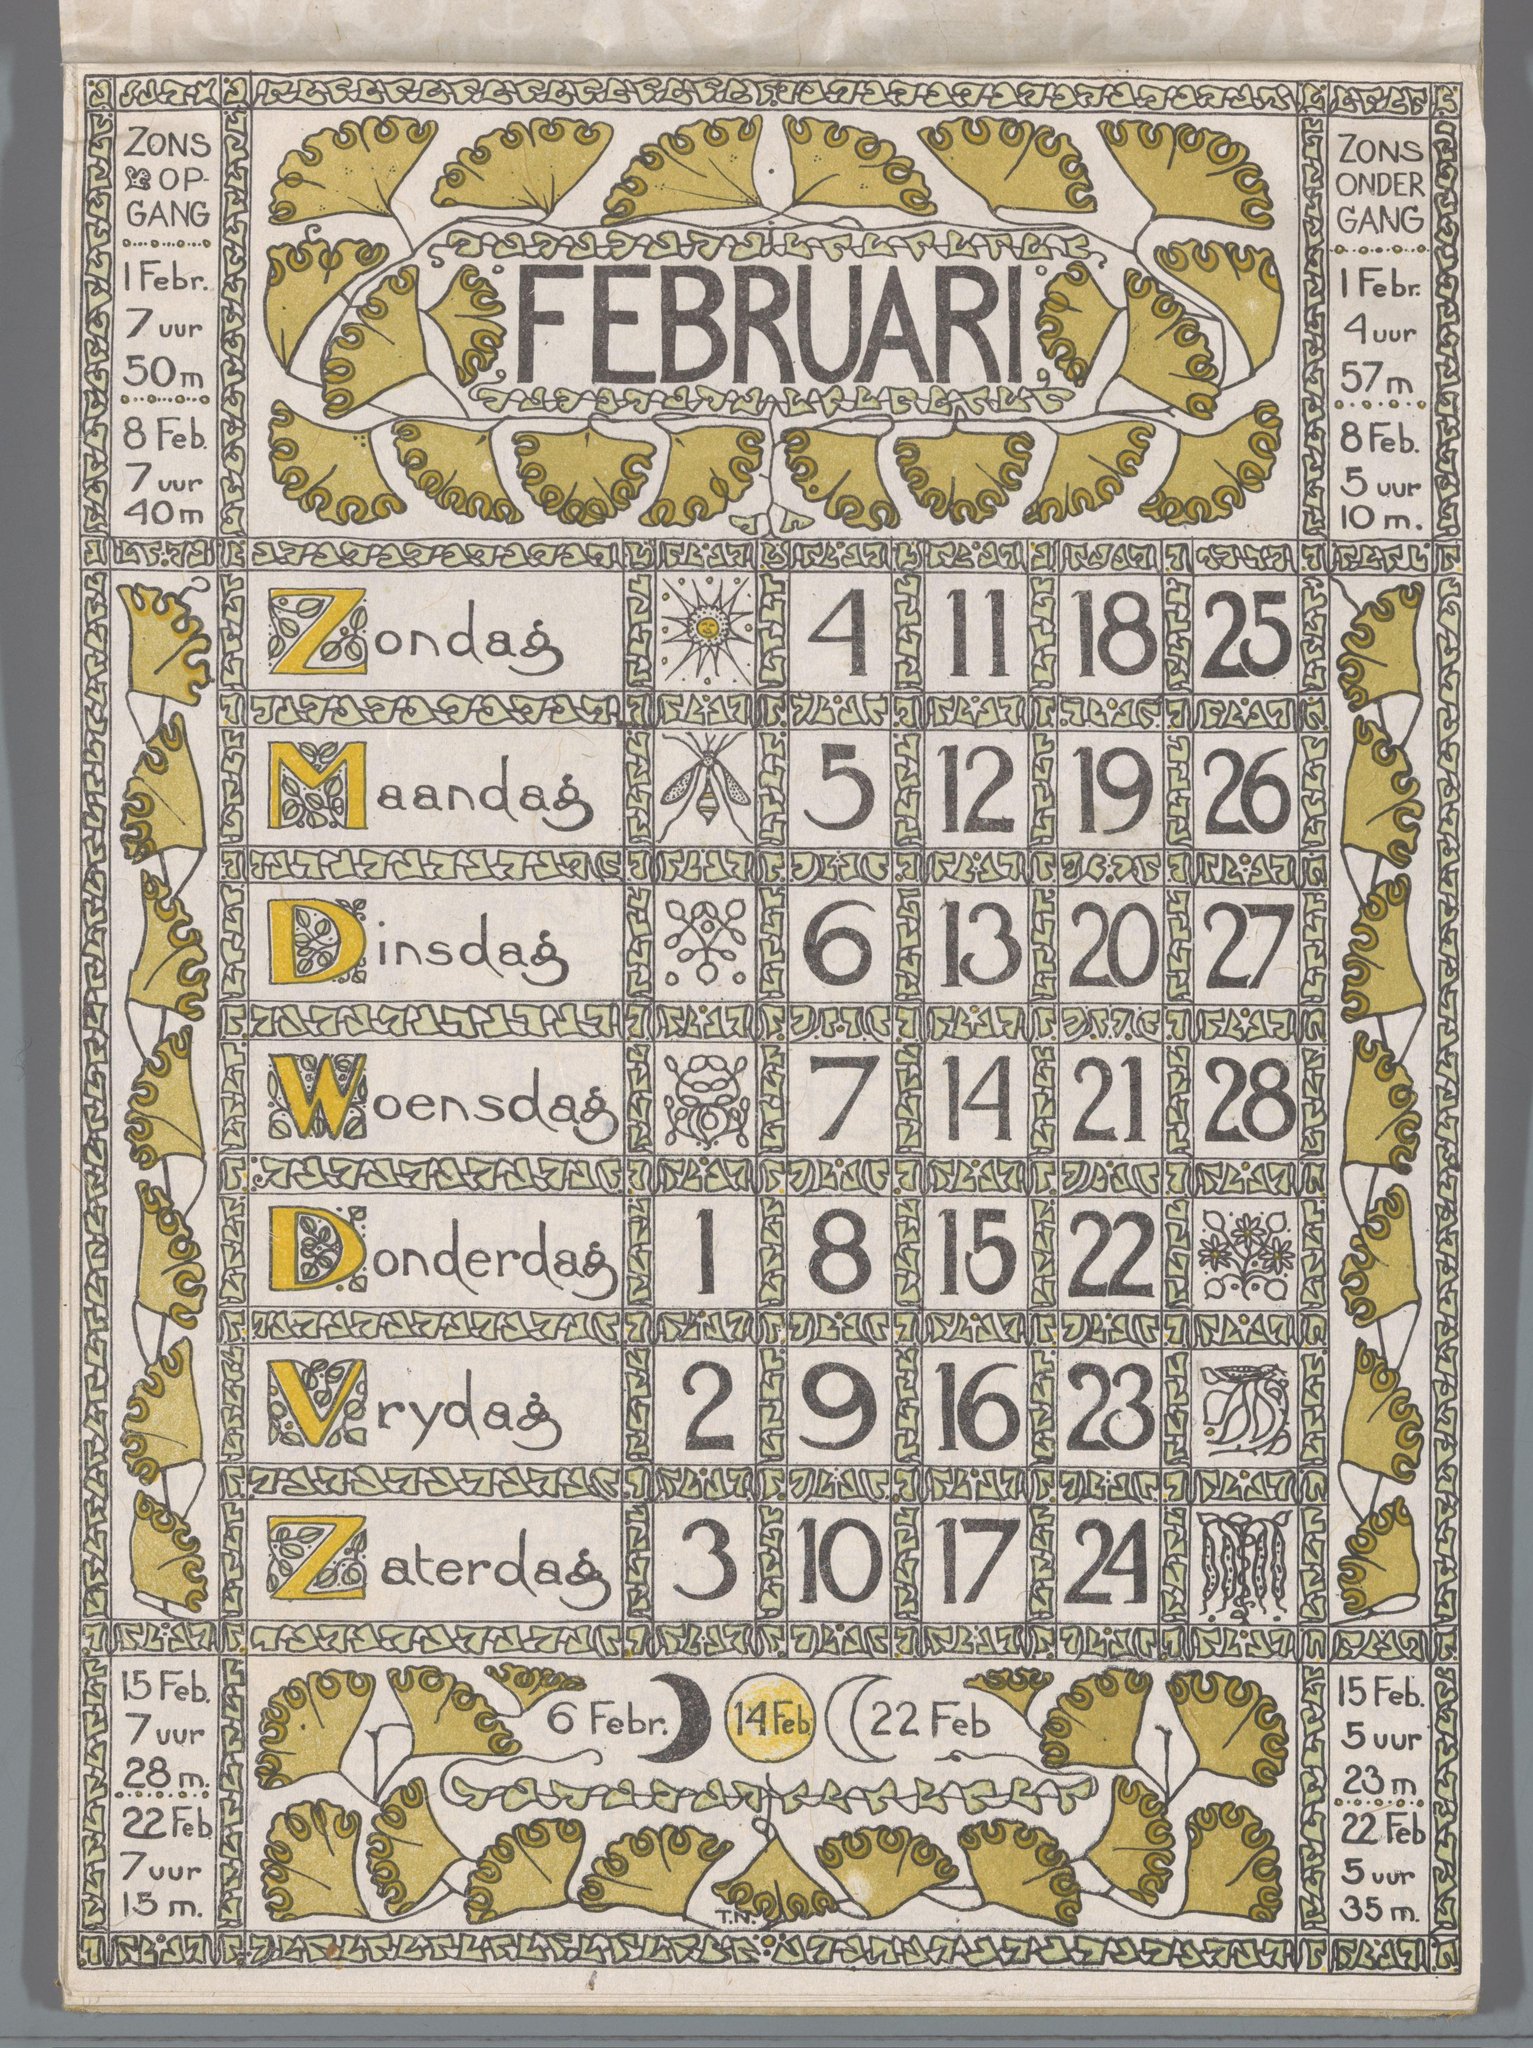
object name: print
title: Kalenderblad februari 1900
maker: theo nieuwenhuis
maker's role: designer, draughtsman, print maker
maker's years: 1866-1951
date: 1900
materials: paper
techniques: lithograph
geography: amsterdam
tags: february ~ other concepts